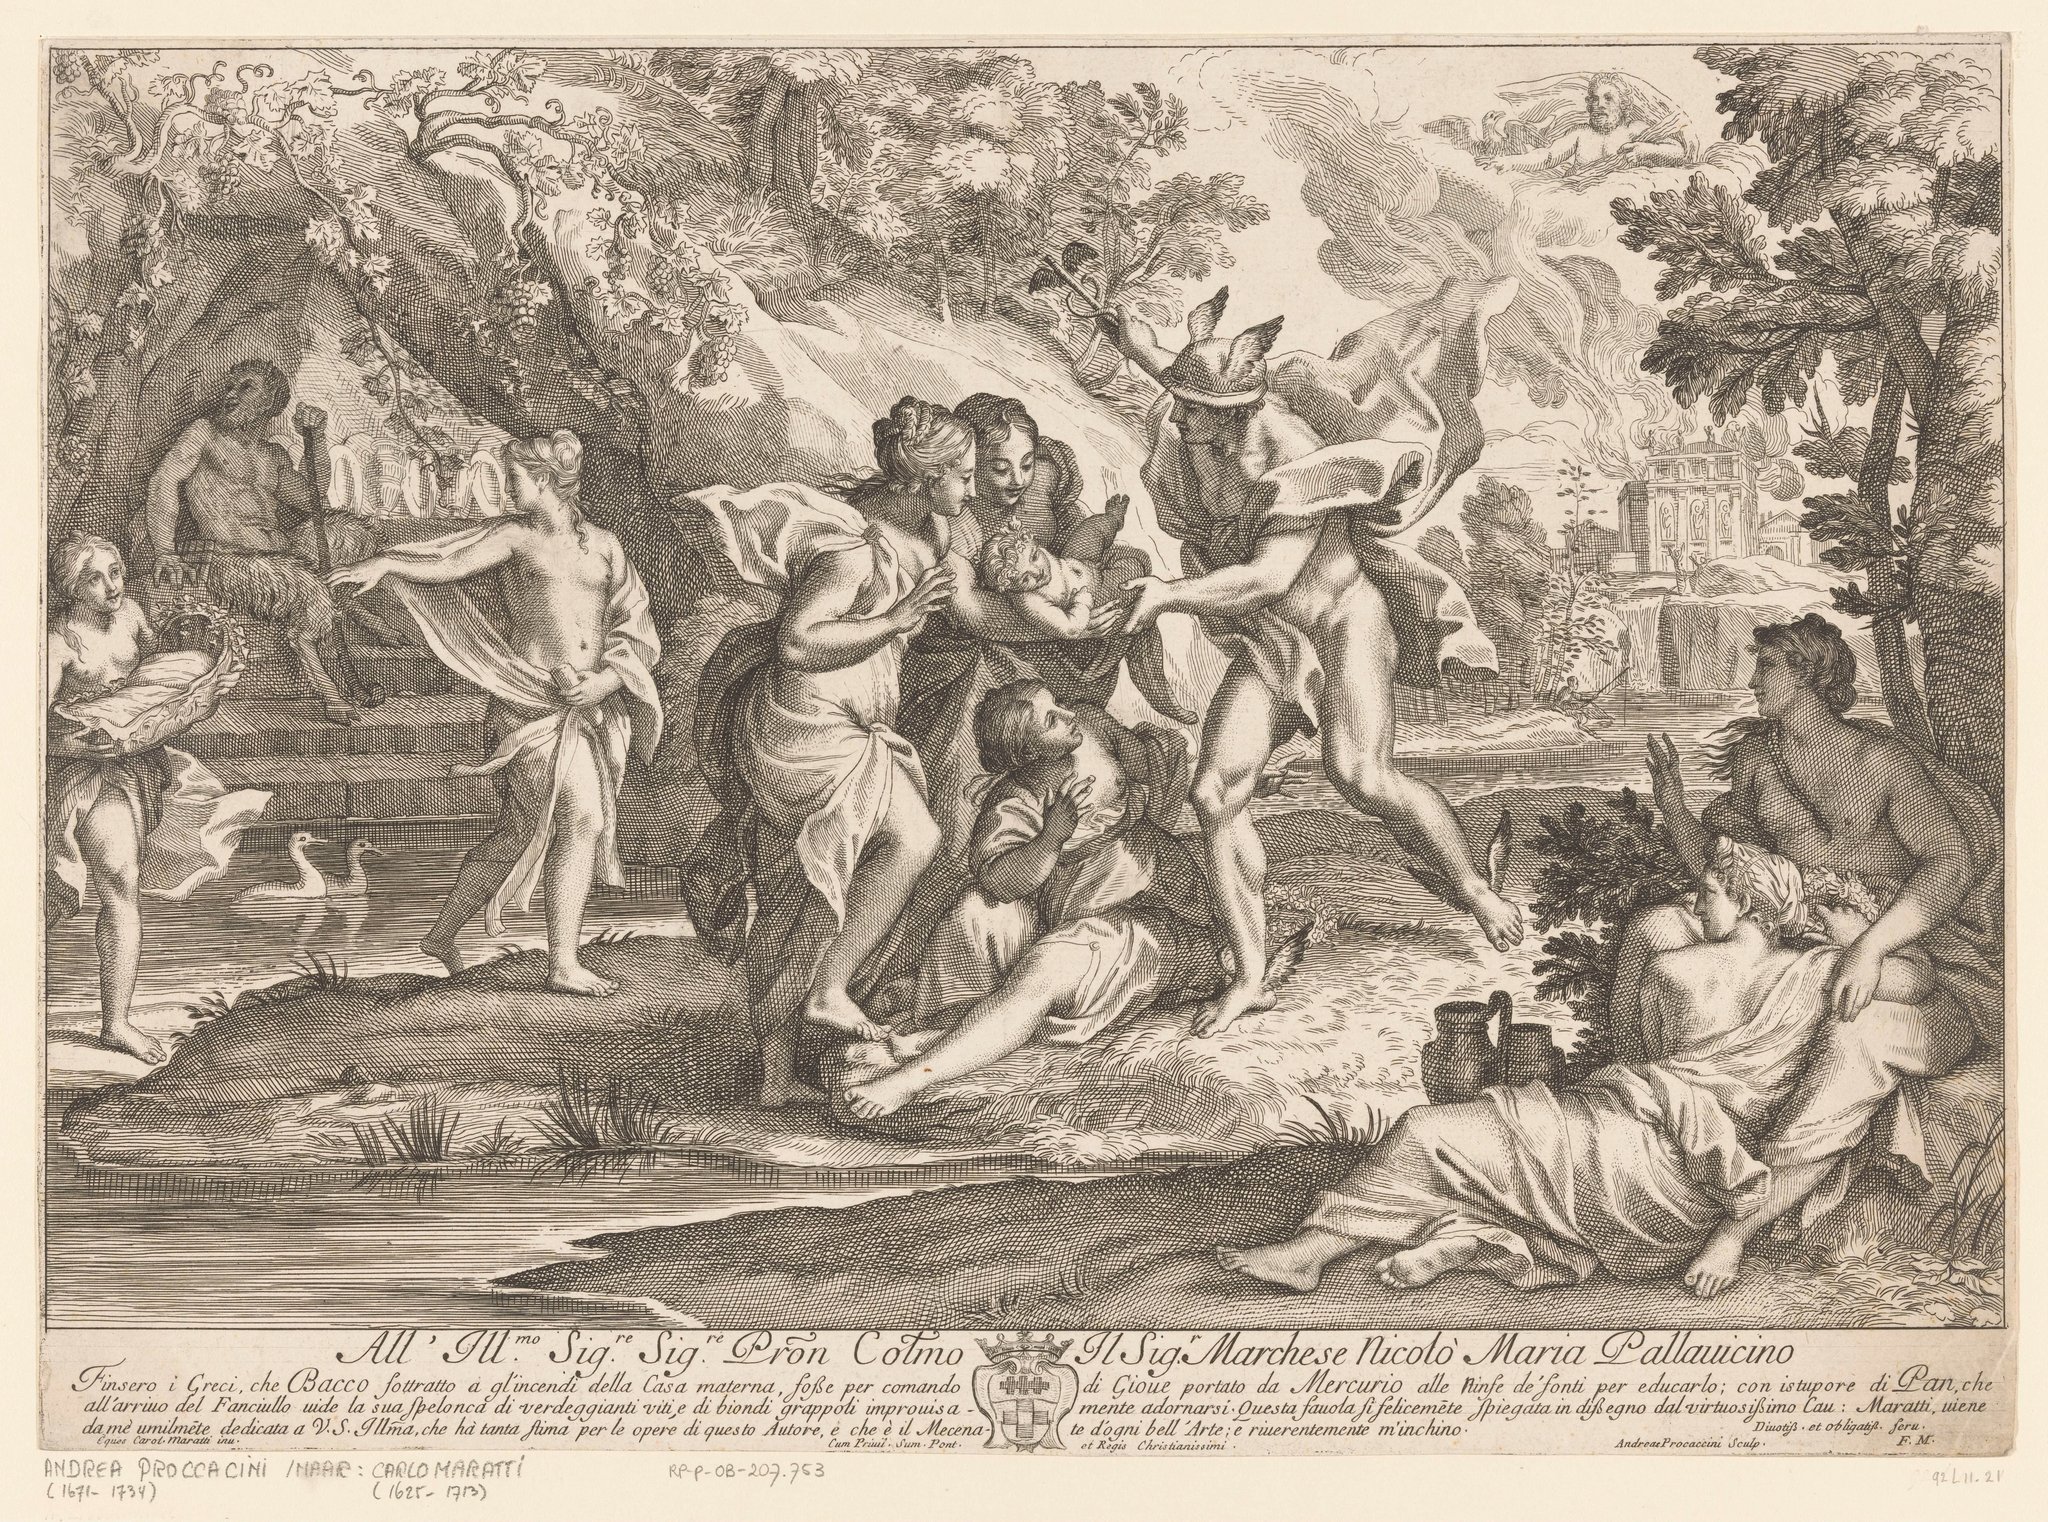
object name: print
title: Mercurius geeft Bacchus aan de nimfen van Nysa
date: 1681-1734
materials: paper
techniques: etching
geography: italy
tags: (story of) mercury (hermes), mercury hands the baby bacchus over to the nymphs of nysa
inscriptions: collector's mark: Lugt 2228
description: Mercurius geeft het kind Bacchus ter opvoeding aan de nimfen van Nysa. Italiaanse tekst en wapenschild in ondermarge.